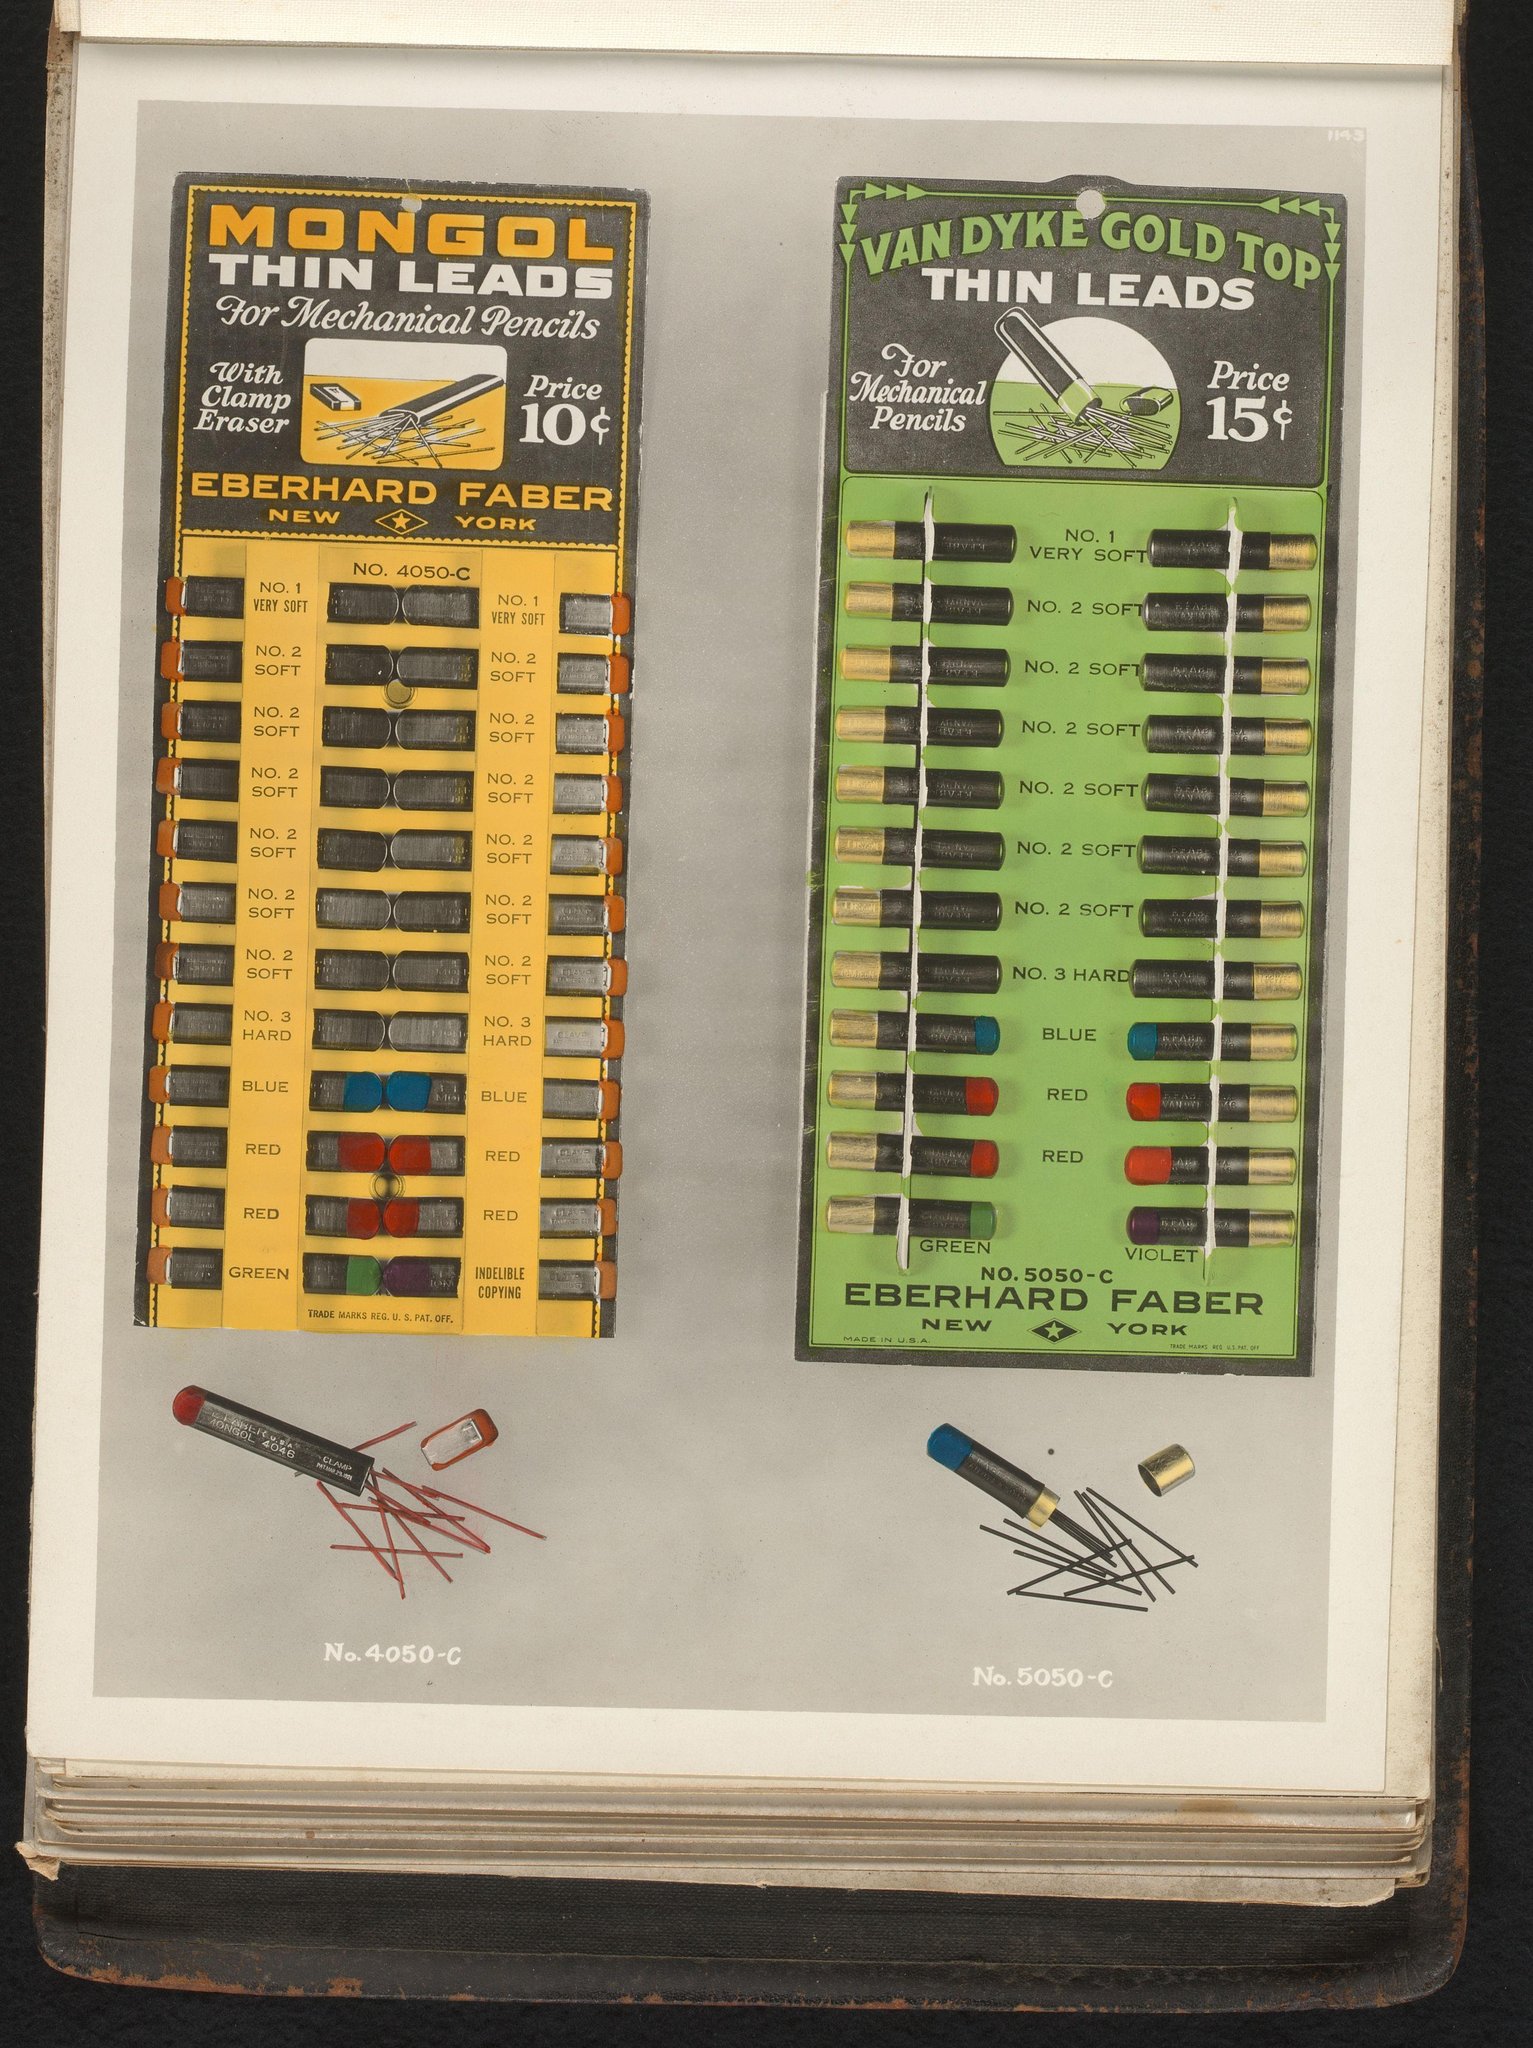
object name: photograph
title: Standaarden met schrijfwaren van Eberhard Faber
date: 1915-1935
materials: paper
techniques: gelatin silver print, hand coloring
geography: springfield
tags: writing tools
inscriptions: number: ‘1143’, stamp: ‘Paramount/ Commercial Studios/ 145 Chestnut St./ Springfield - Mass.’